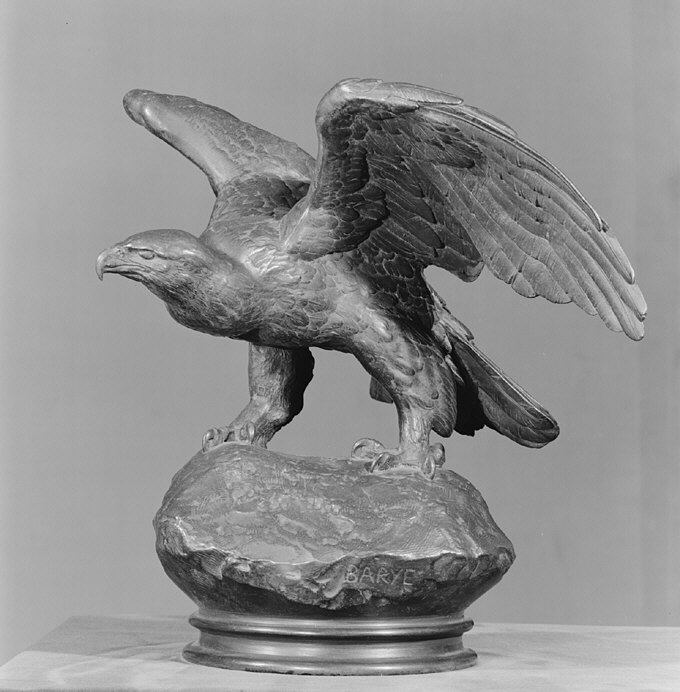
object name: statuette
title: Eagle with Wings Outspread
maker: antoine-louis barye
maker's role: artist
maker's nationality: french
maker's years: 1795-1875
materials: bronze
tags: eagles